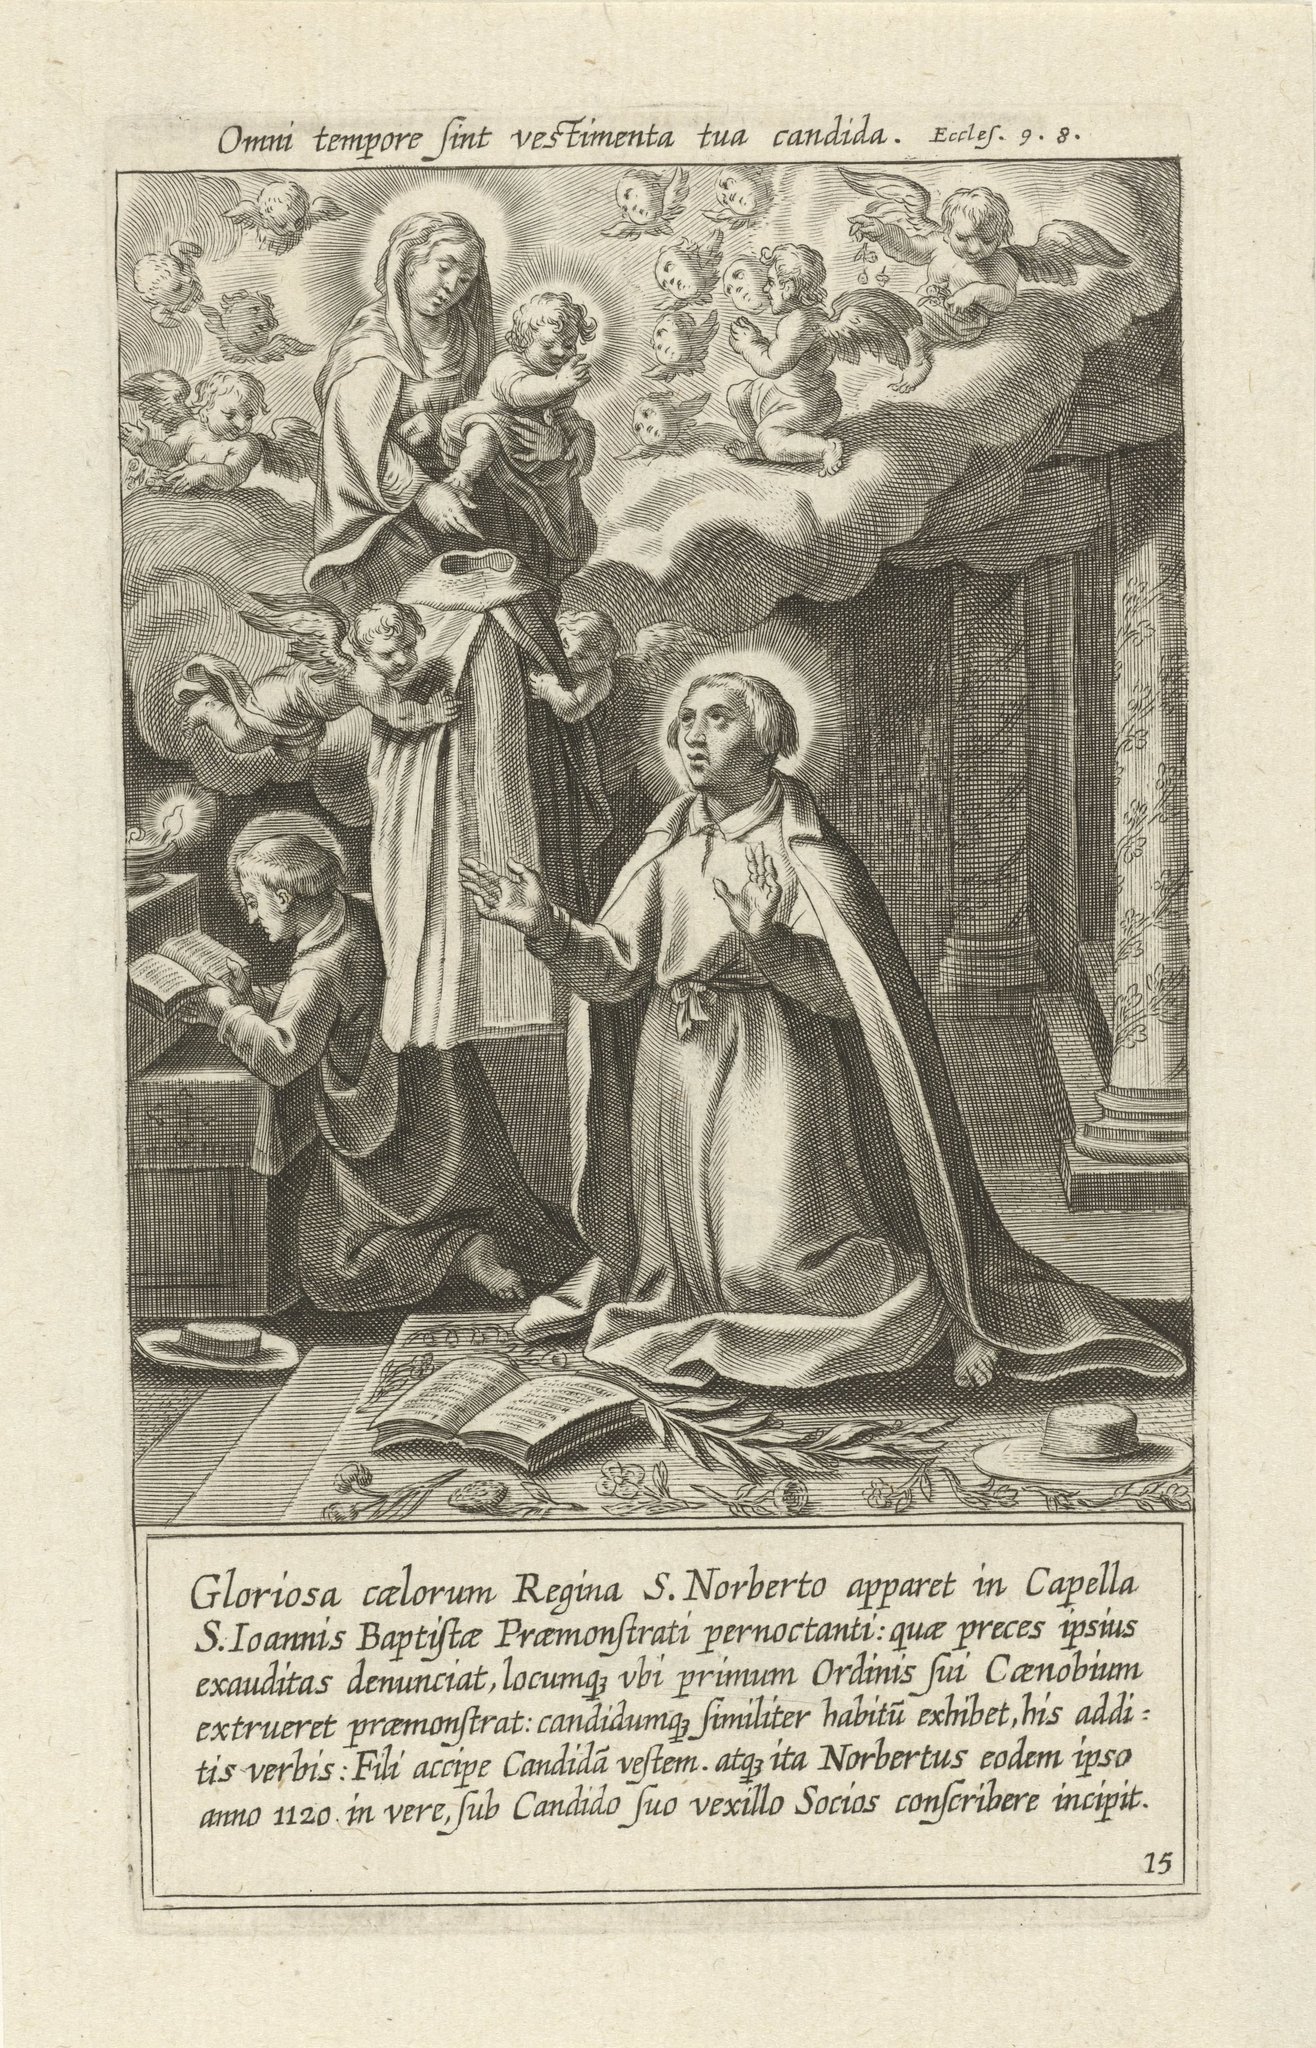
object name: book illustration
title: Visioen van de maagd Maria met Christuskind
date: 1622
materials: paper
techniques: engraving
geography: antwerp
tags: the virgin mary gives st. norbert a scapular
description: Tijdens het gebed krijgt de heilige Norbertus een visioen van de maagd Maria en het Christuskind. Christus beveelt hem een orde te stichten en toont hem het witte habijt van de orde der Norbertijnen. De prent heeft twee Latijnse opschriften: een boven en een onder de voorstelling.